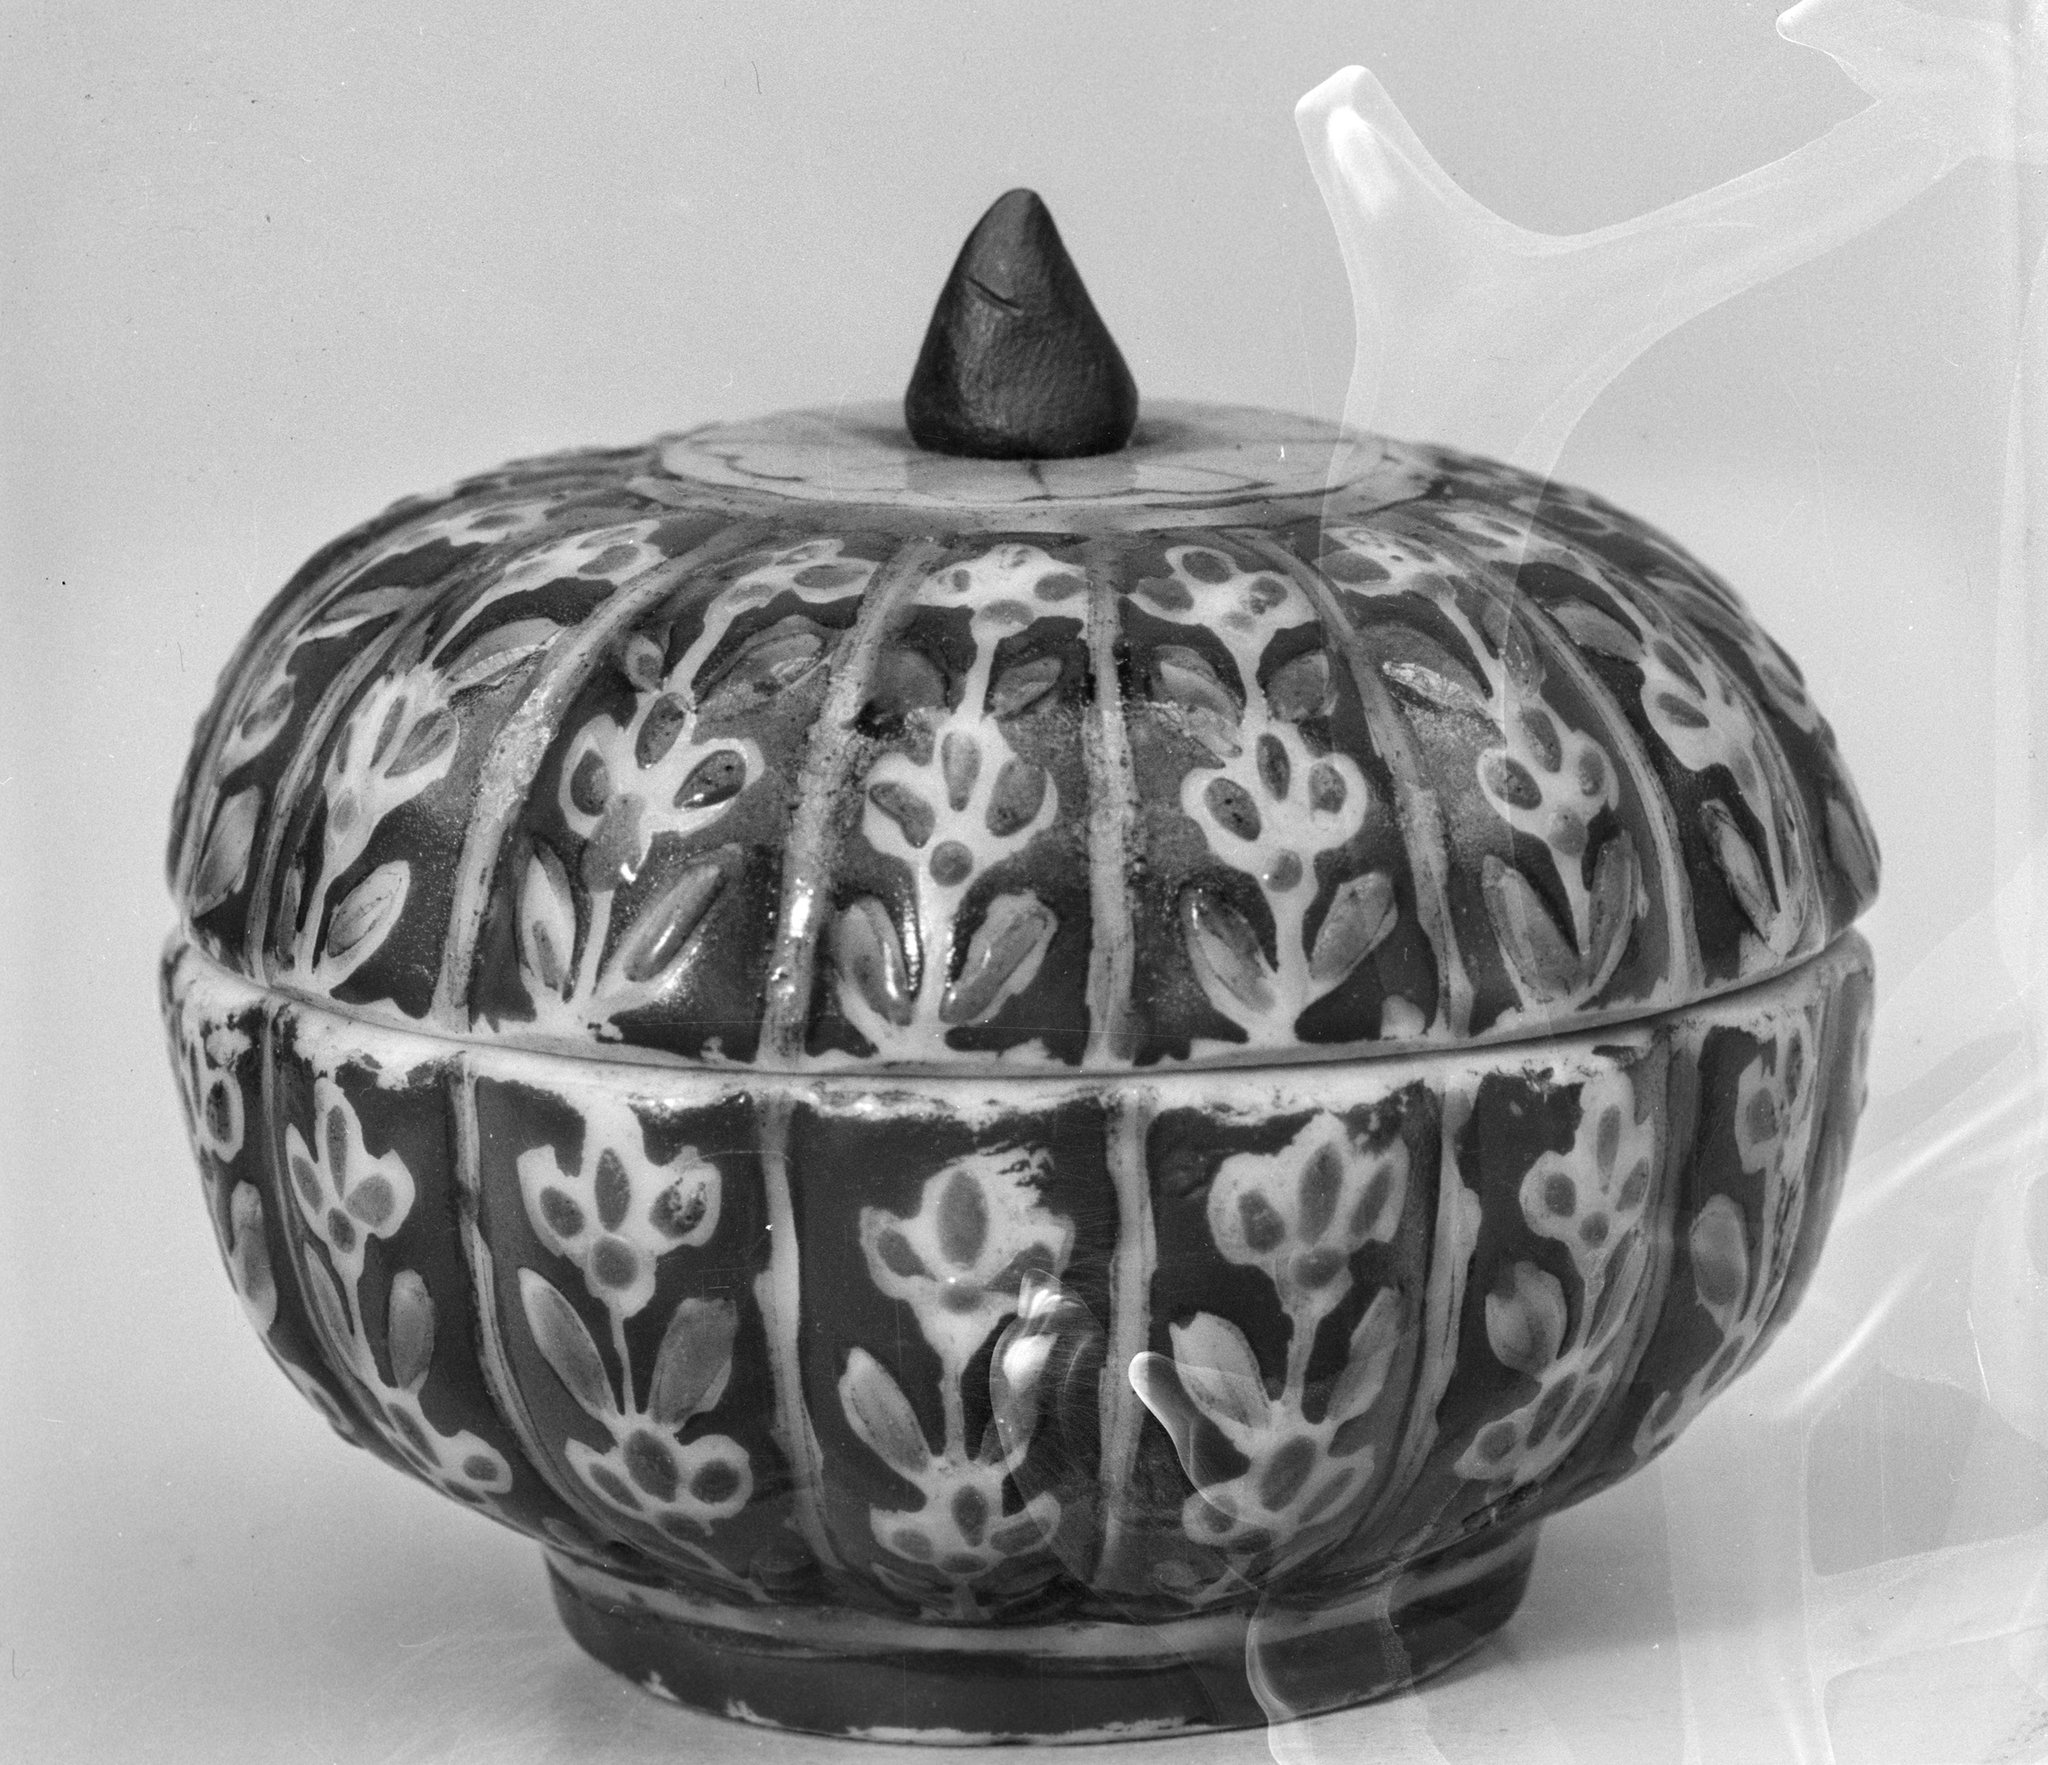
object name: covered box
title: Covered box with floral pattern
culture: chinese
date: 1801-1900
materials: enamel, porcelain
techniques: overglaze, painting, polychrome